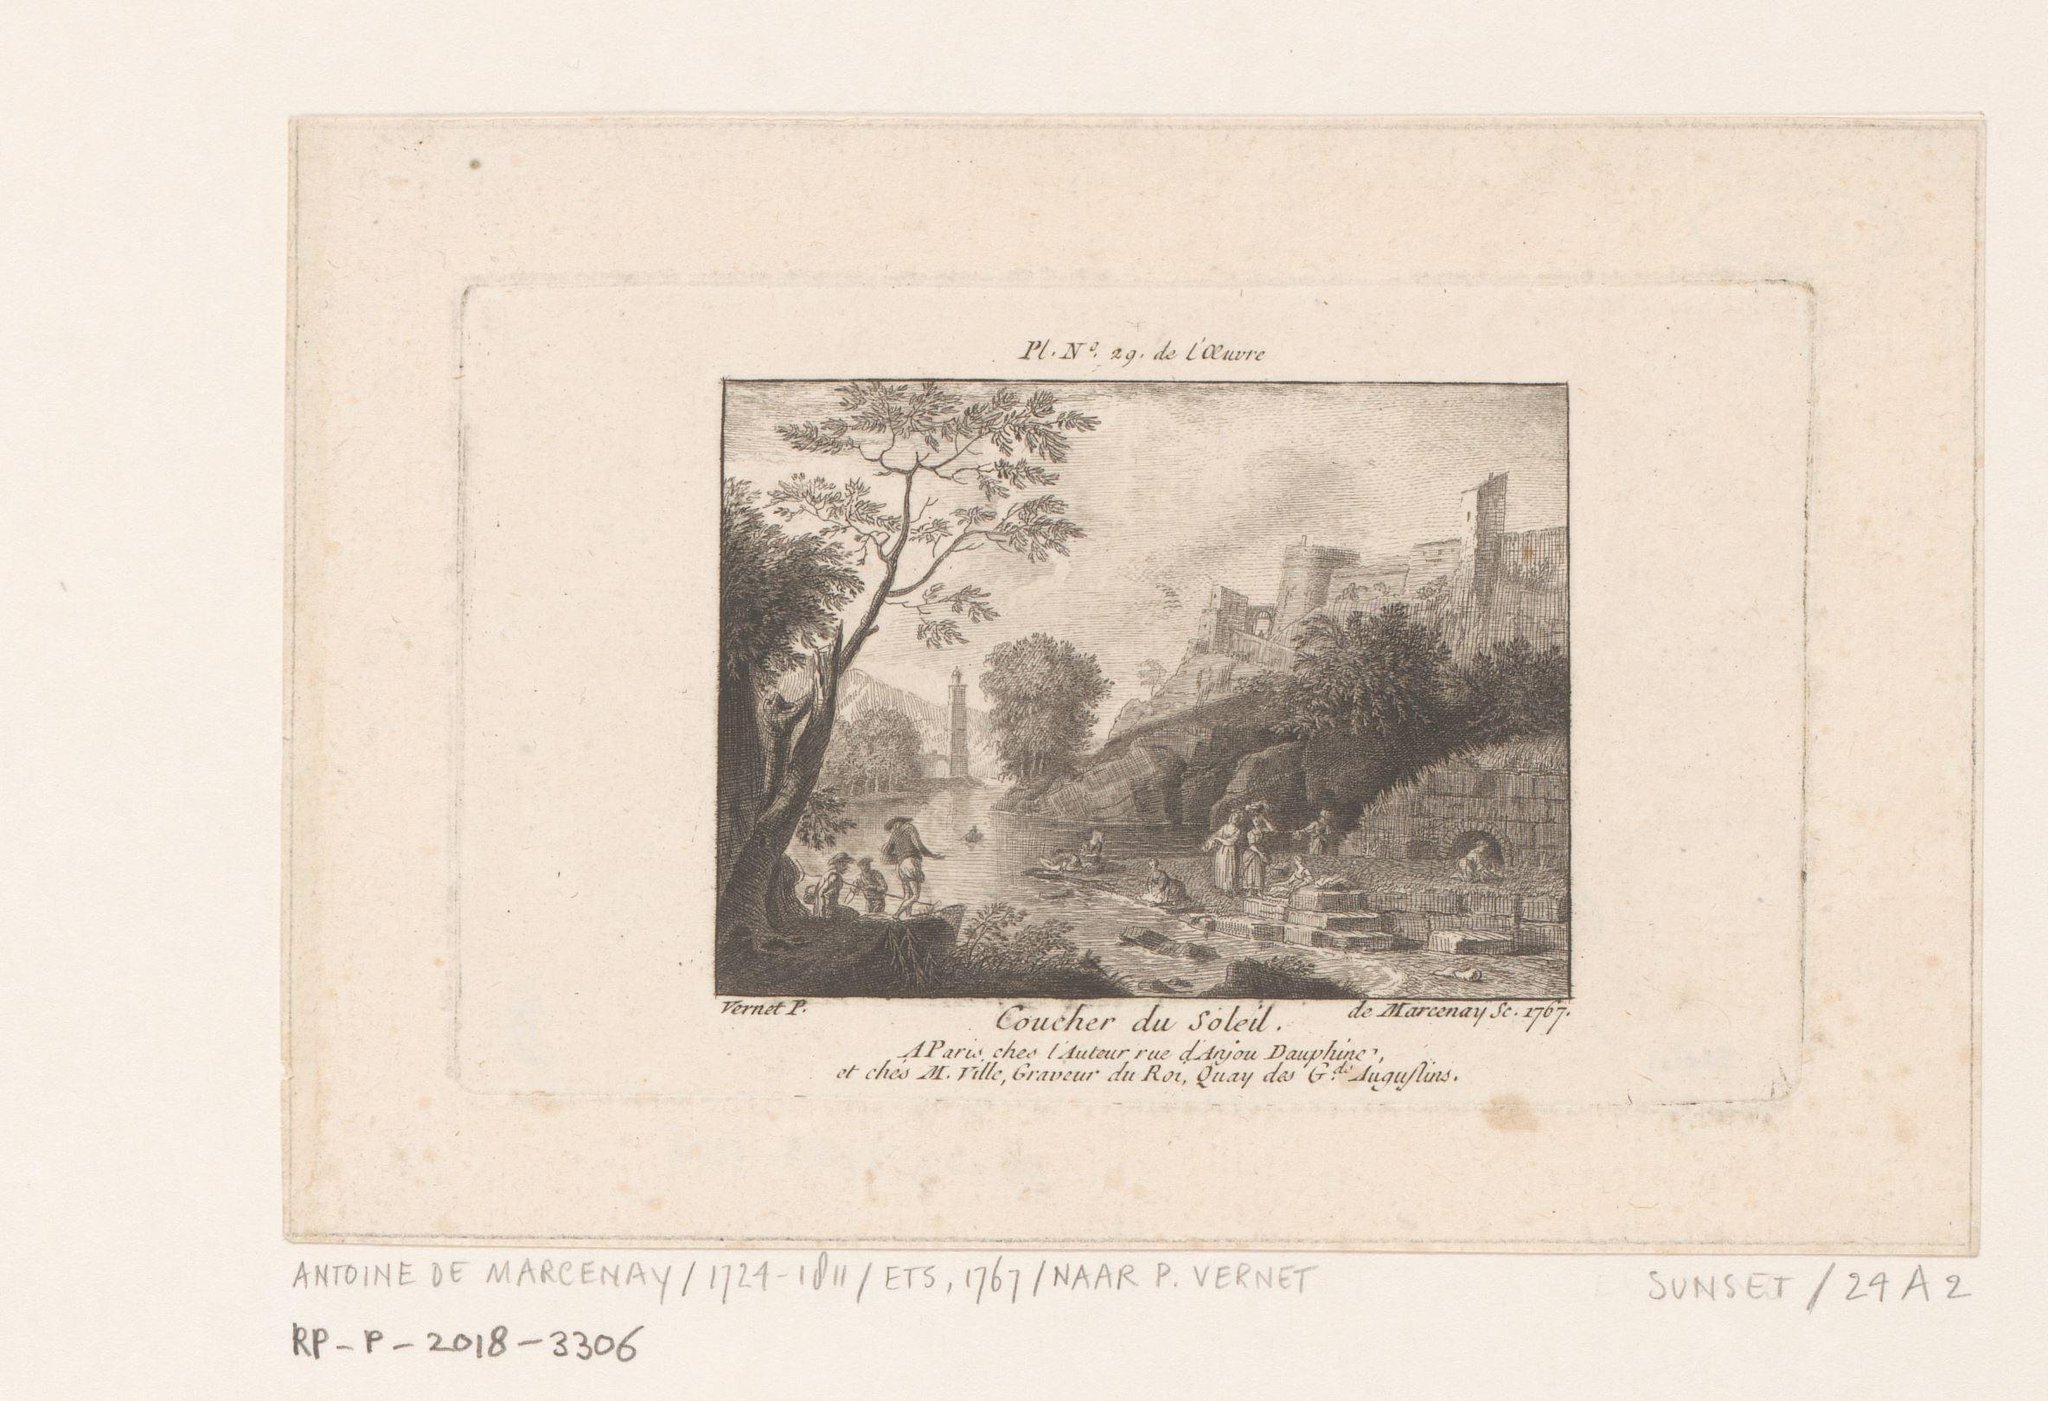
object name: print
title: Rivierlandschap met wasvrouwen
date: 1767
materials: paper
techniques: etching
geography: paris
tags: river, laundering, sunset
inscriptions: collector's mark: Lugt 2228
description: Genummerd midden boven: Pl. No. 29. de l'Oeuvre.